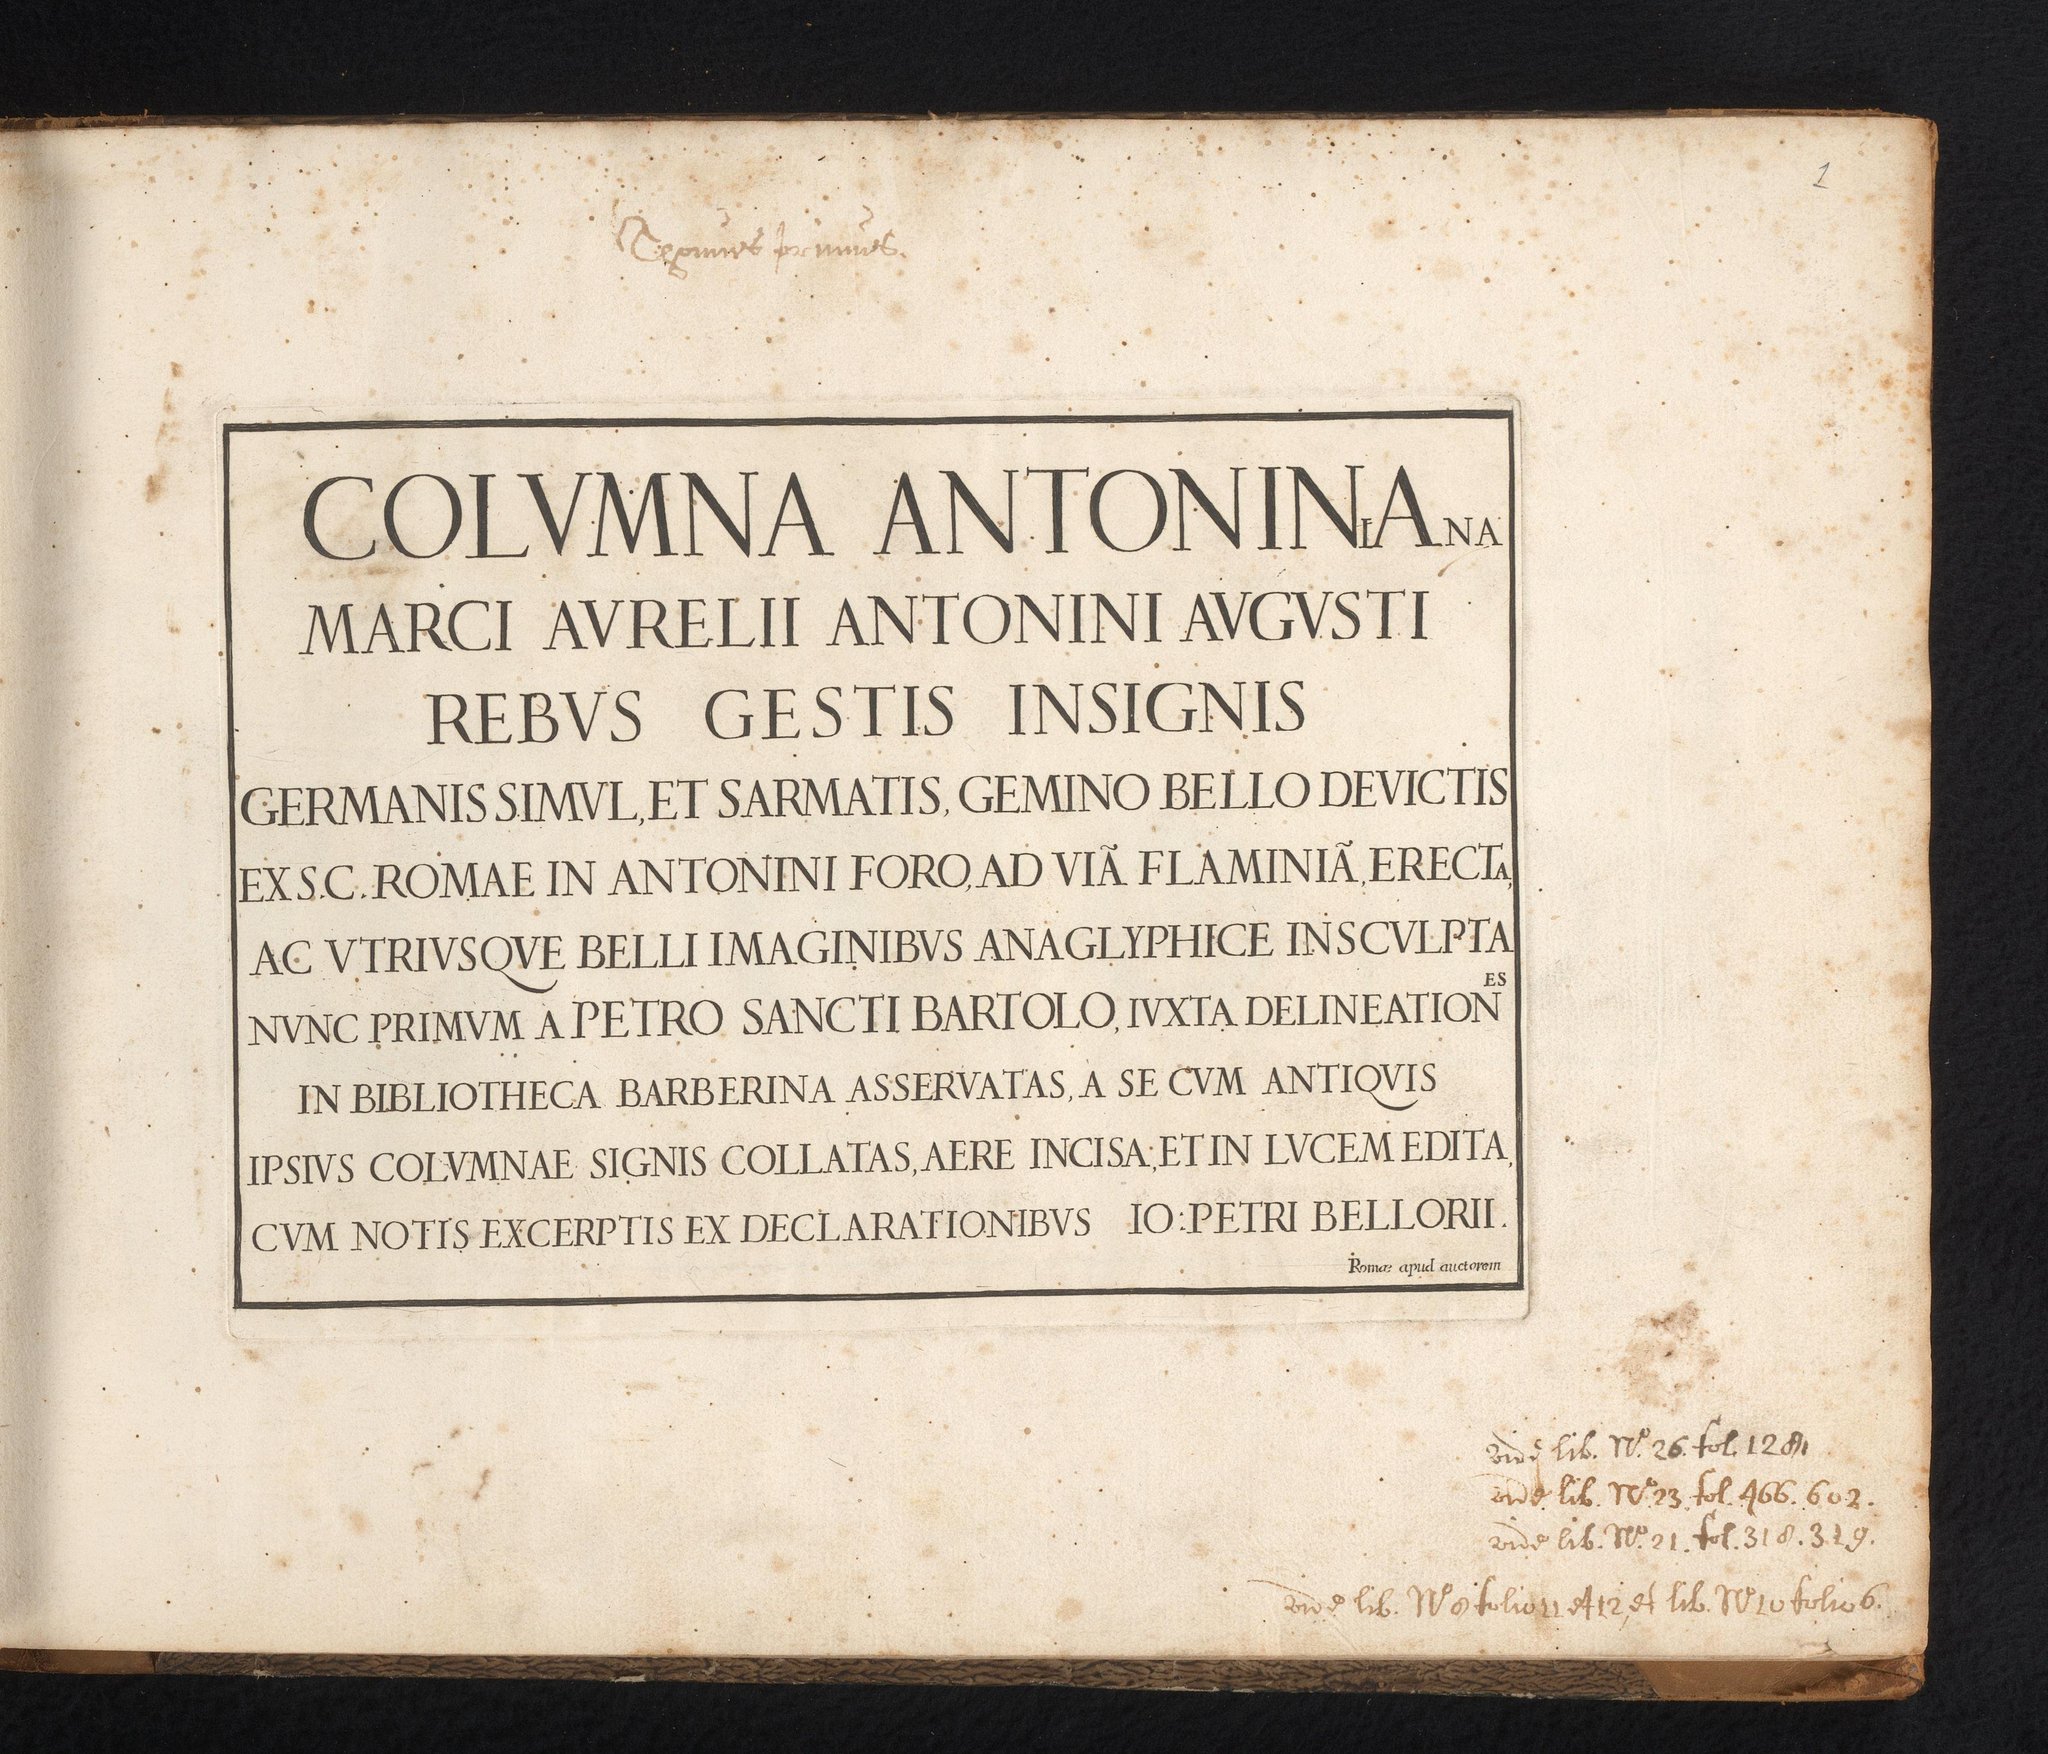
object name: album leaf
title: Titelprent bij een reeks prenten van de Zuil van Marcus Aurelius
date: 1672-1675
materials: paper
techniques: etching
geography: rome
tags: zuil van marcus aurelius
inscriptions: inscription: ‘Ende lib. No. 26. fol. 1281/ Ende lib. No. 23. fol. 466. 602...’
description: Titelprent bij een reeks van 77 prenten (alleen de eerste 75 zijn genummerd) met voorstellingen van de Zuil van Marcus Aurelius.